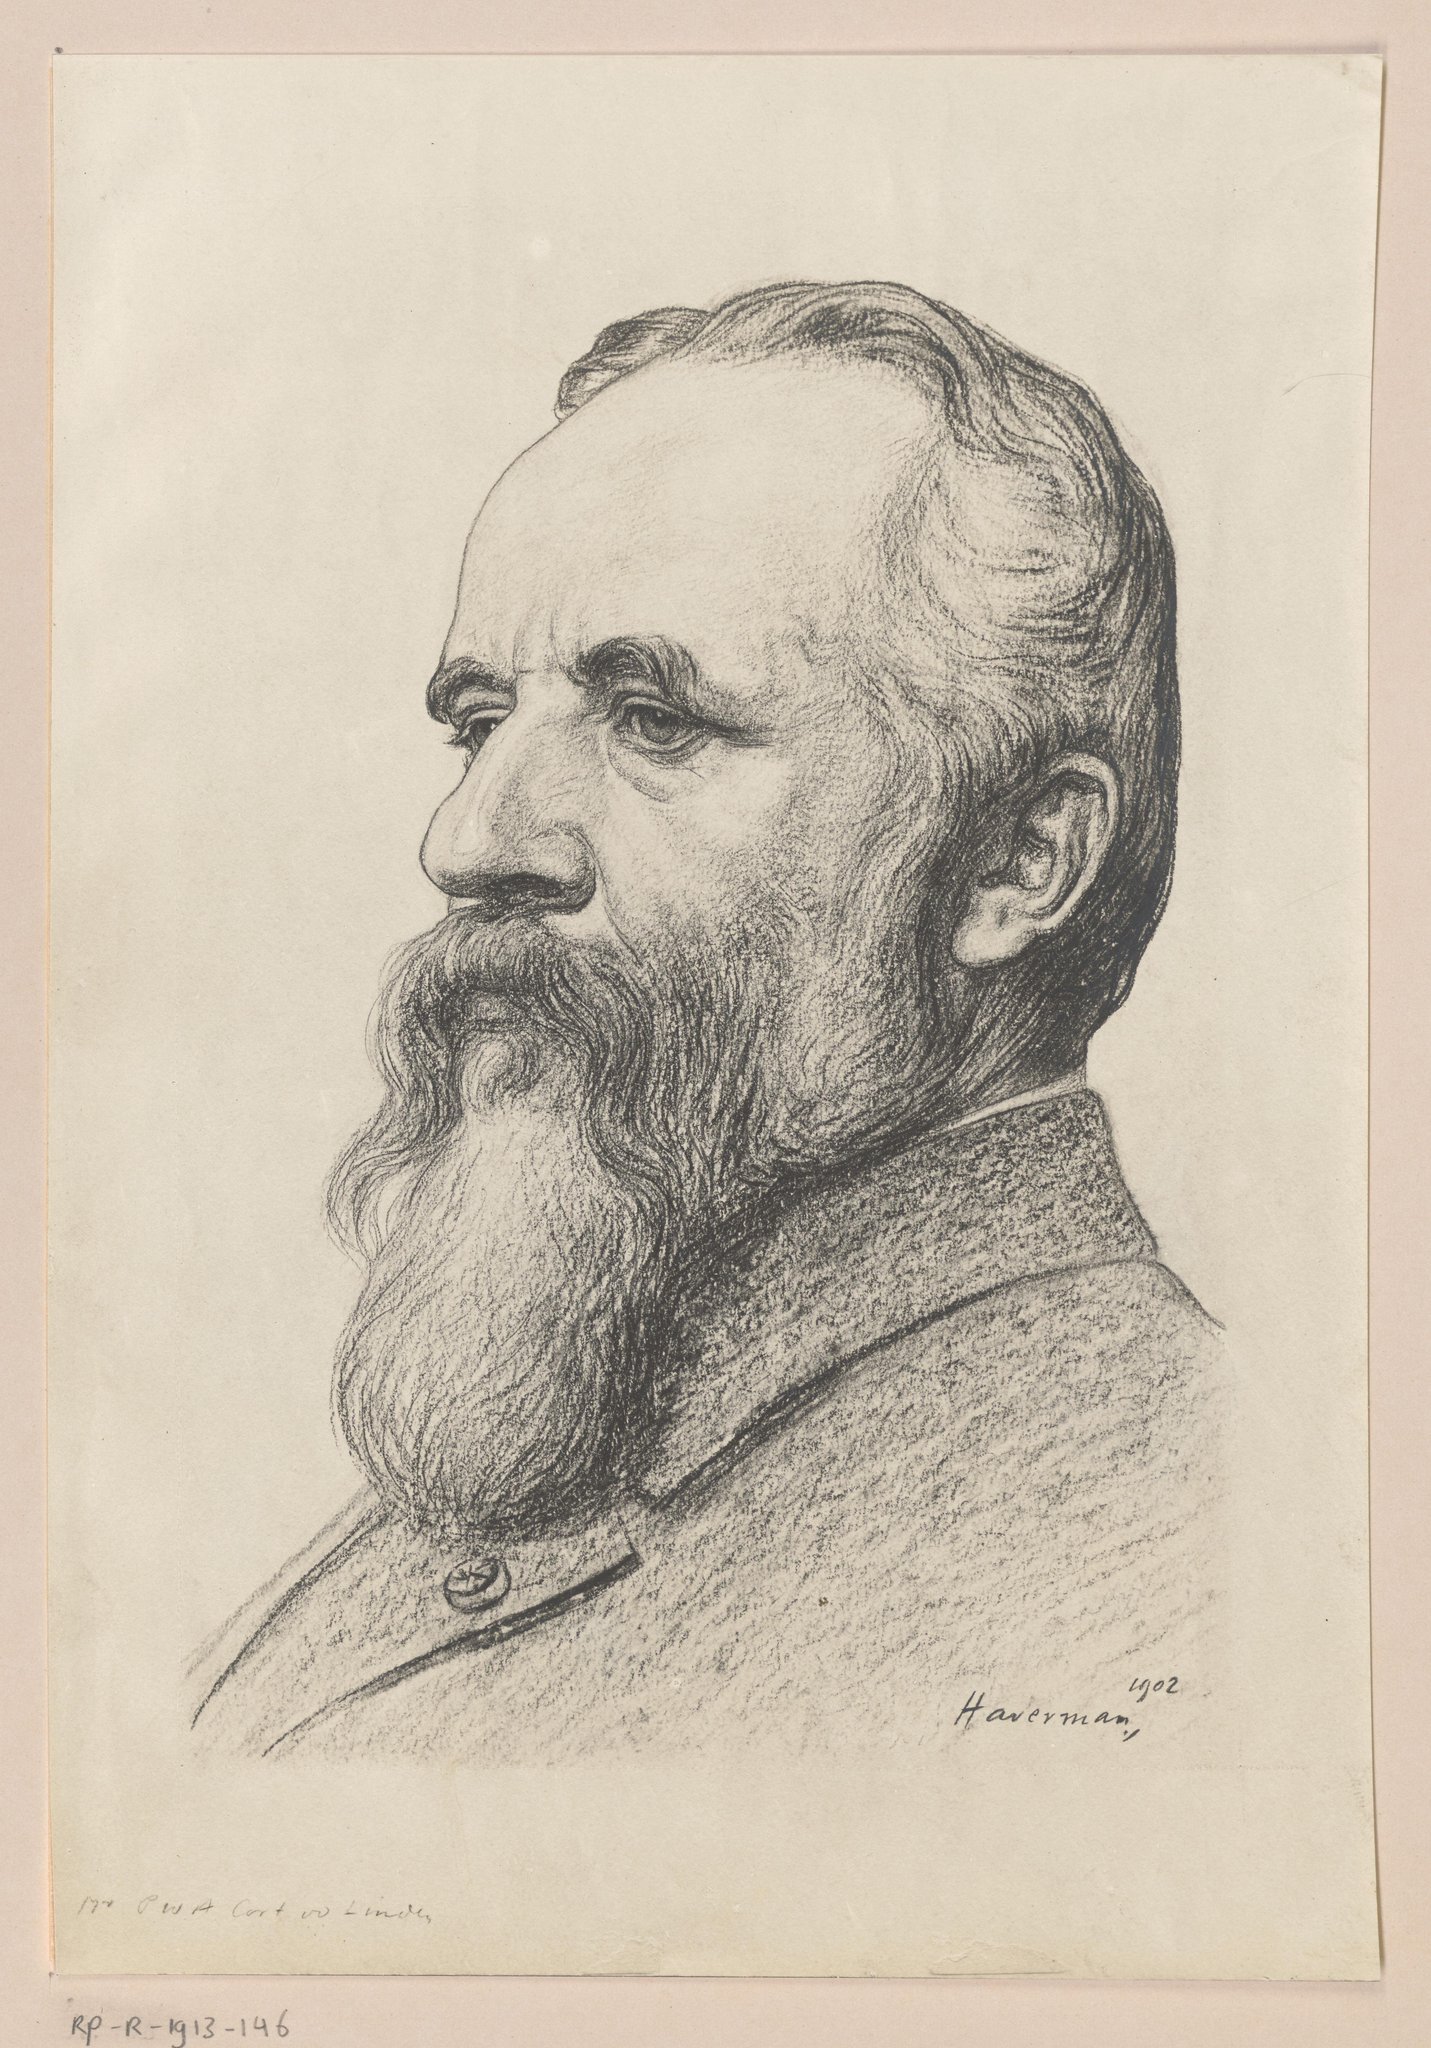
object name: photomechanical print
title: Portret van Pieter Wilhelm Adriaan Cort van der Linden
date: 1902-1913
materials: paper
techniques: photograph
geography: netherlands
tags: the hague, politician, historical persons, politician, e.g. party leader